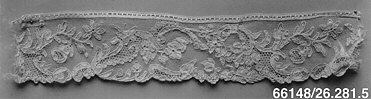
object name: strip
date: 1801-1900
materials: lace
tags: flowers